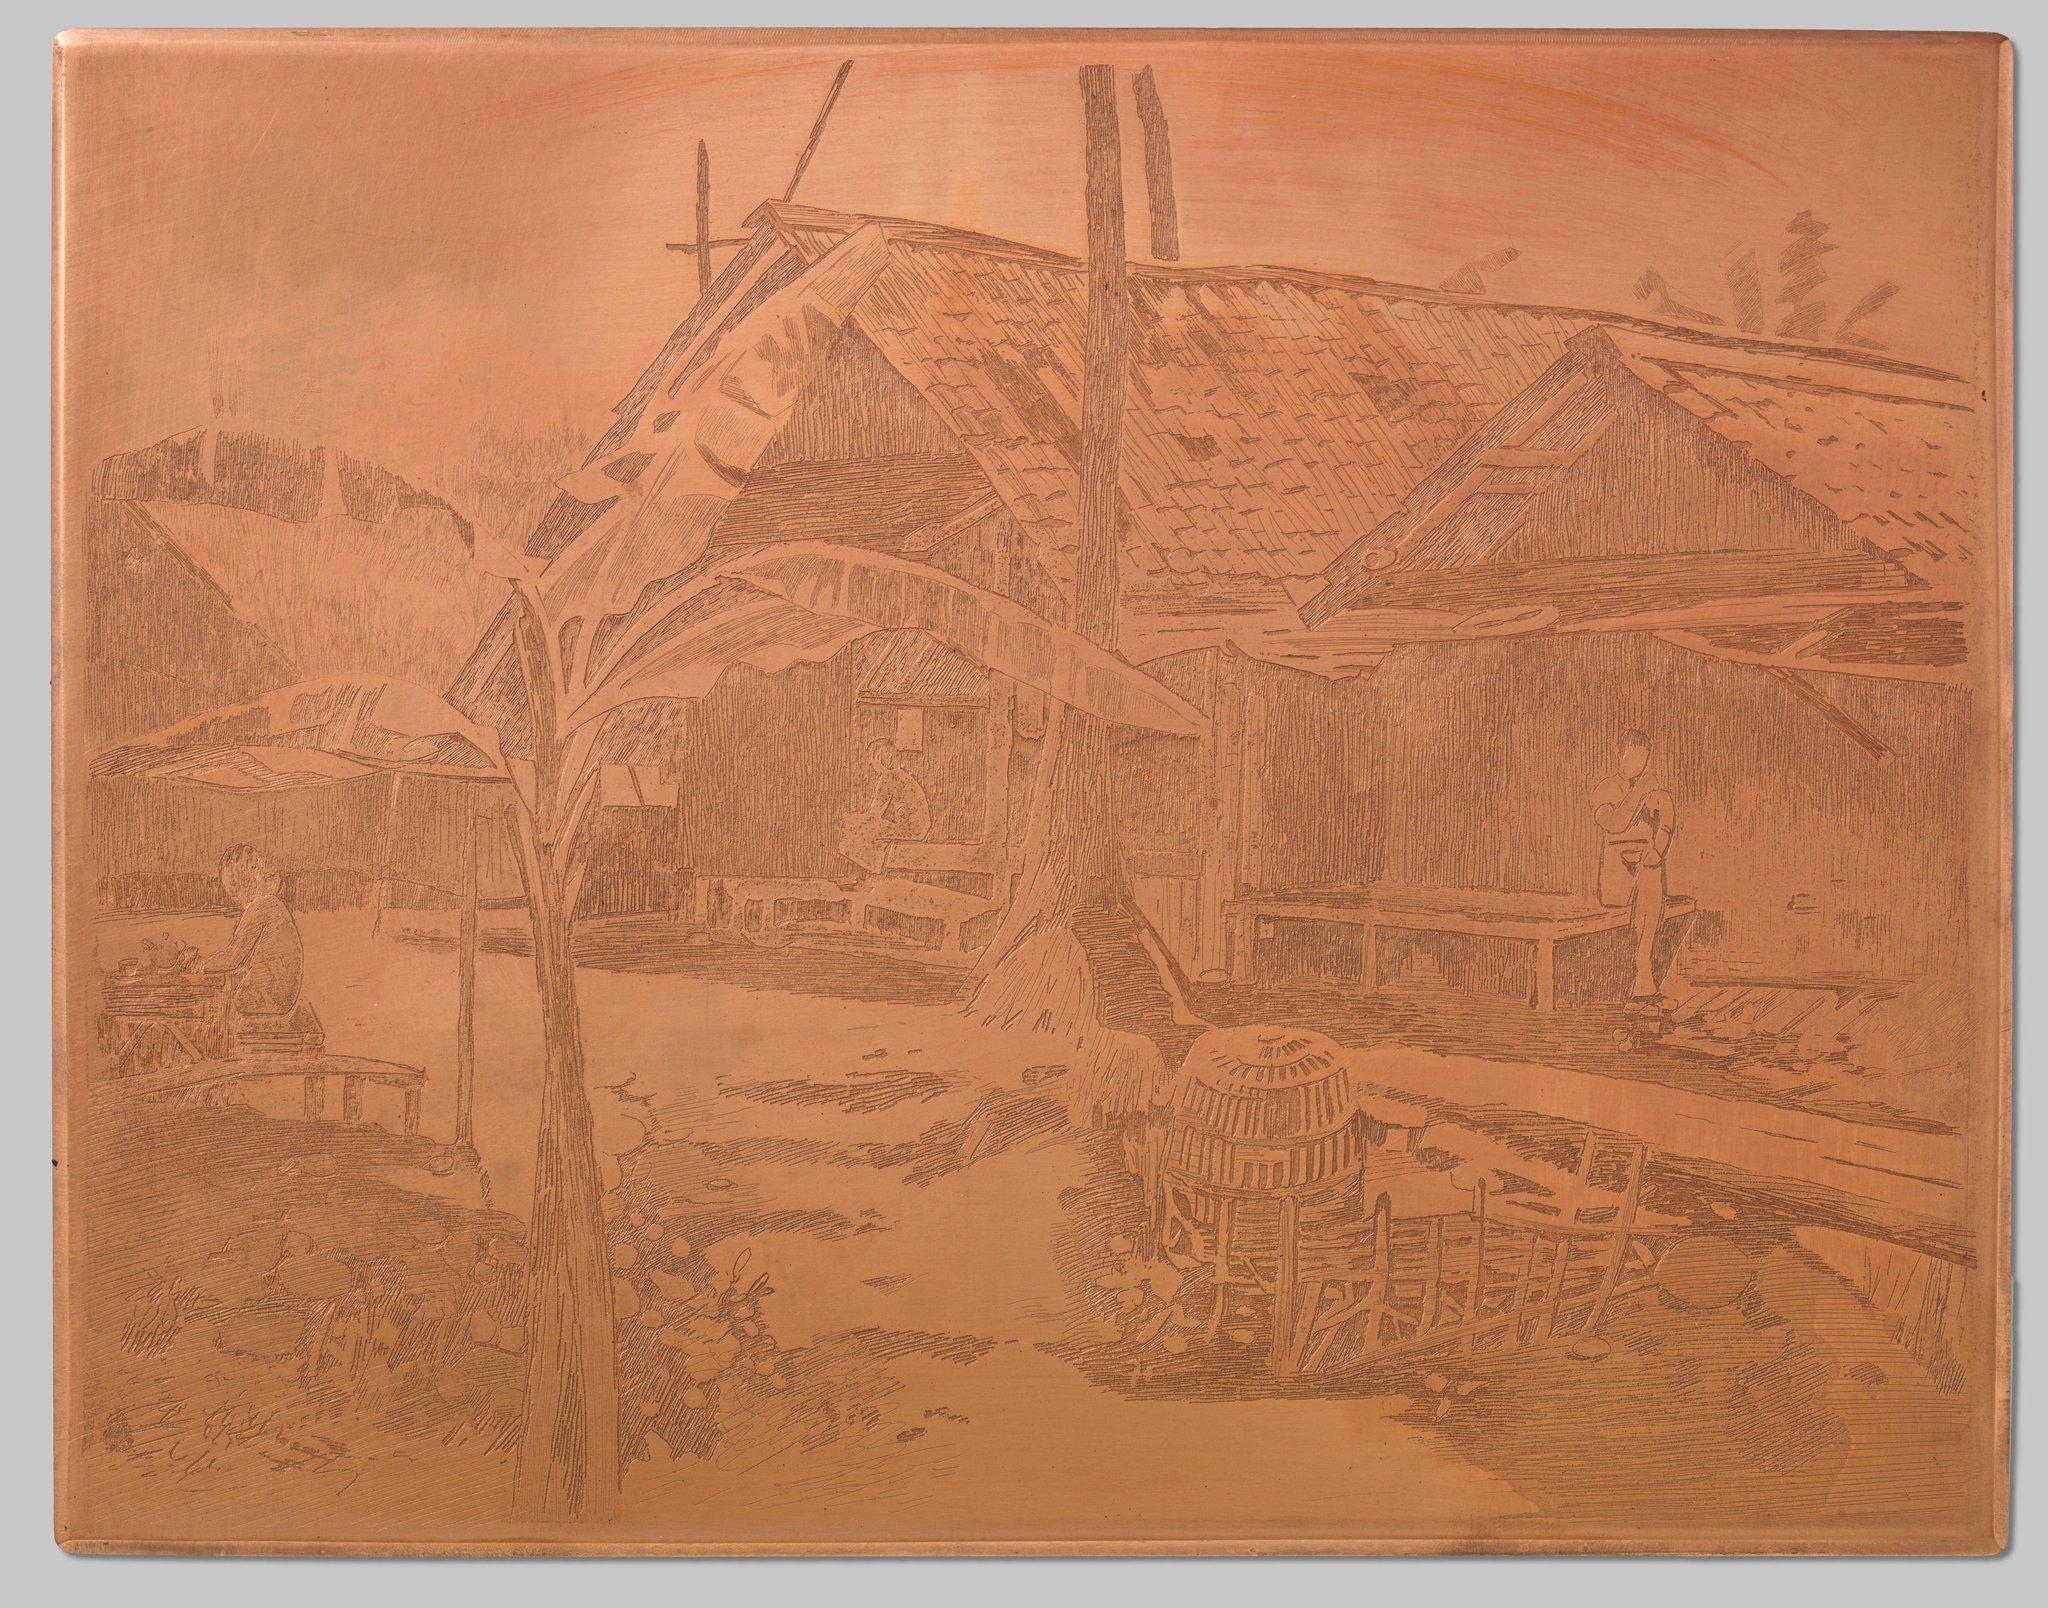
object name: copper plate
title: In de kampong, pisangboom op de voorgrond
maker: willem witsen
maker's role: draughtsman, painter, print maker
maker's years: 1860-1923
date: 1921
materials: copper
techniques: etching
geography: buitenzorg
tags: buitenzorg